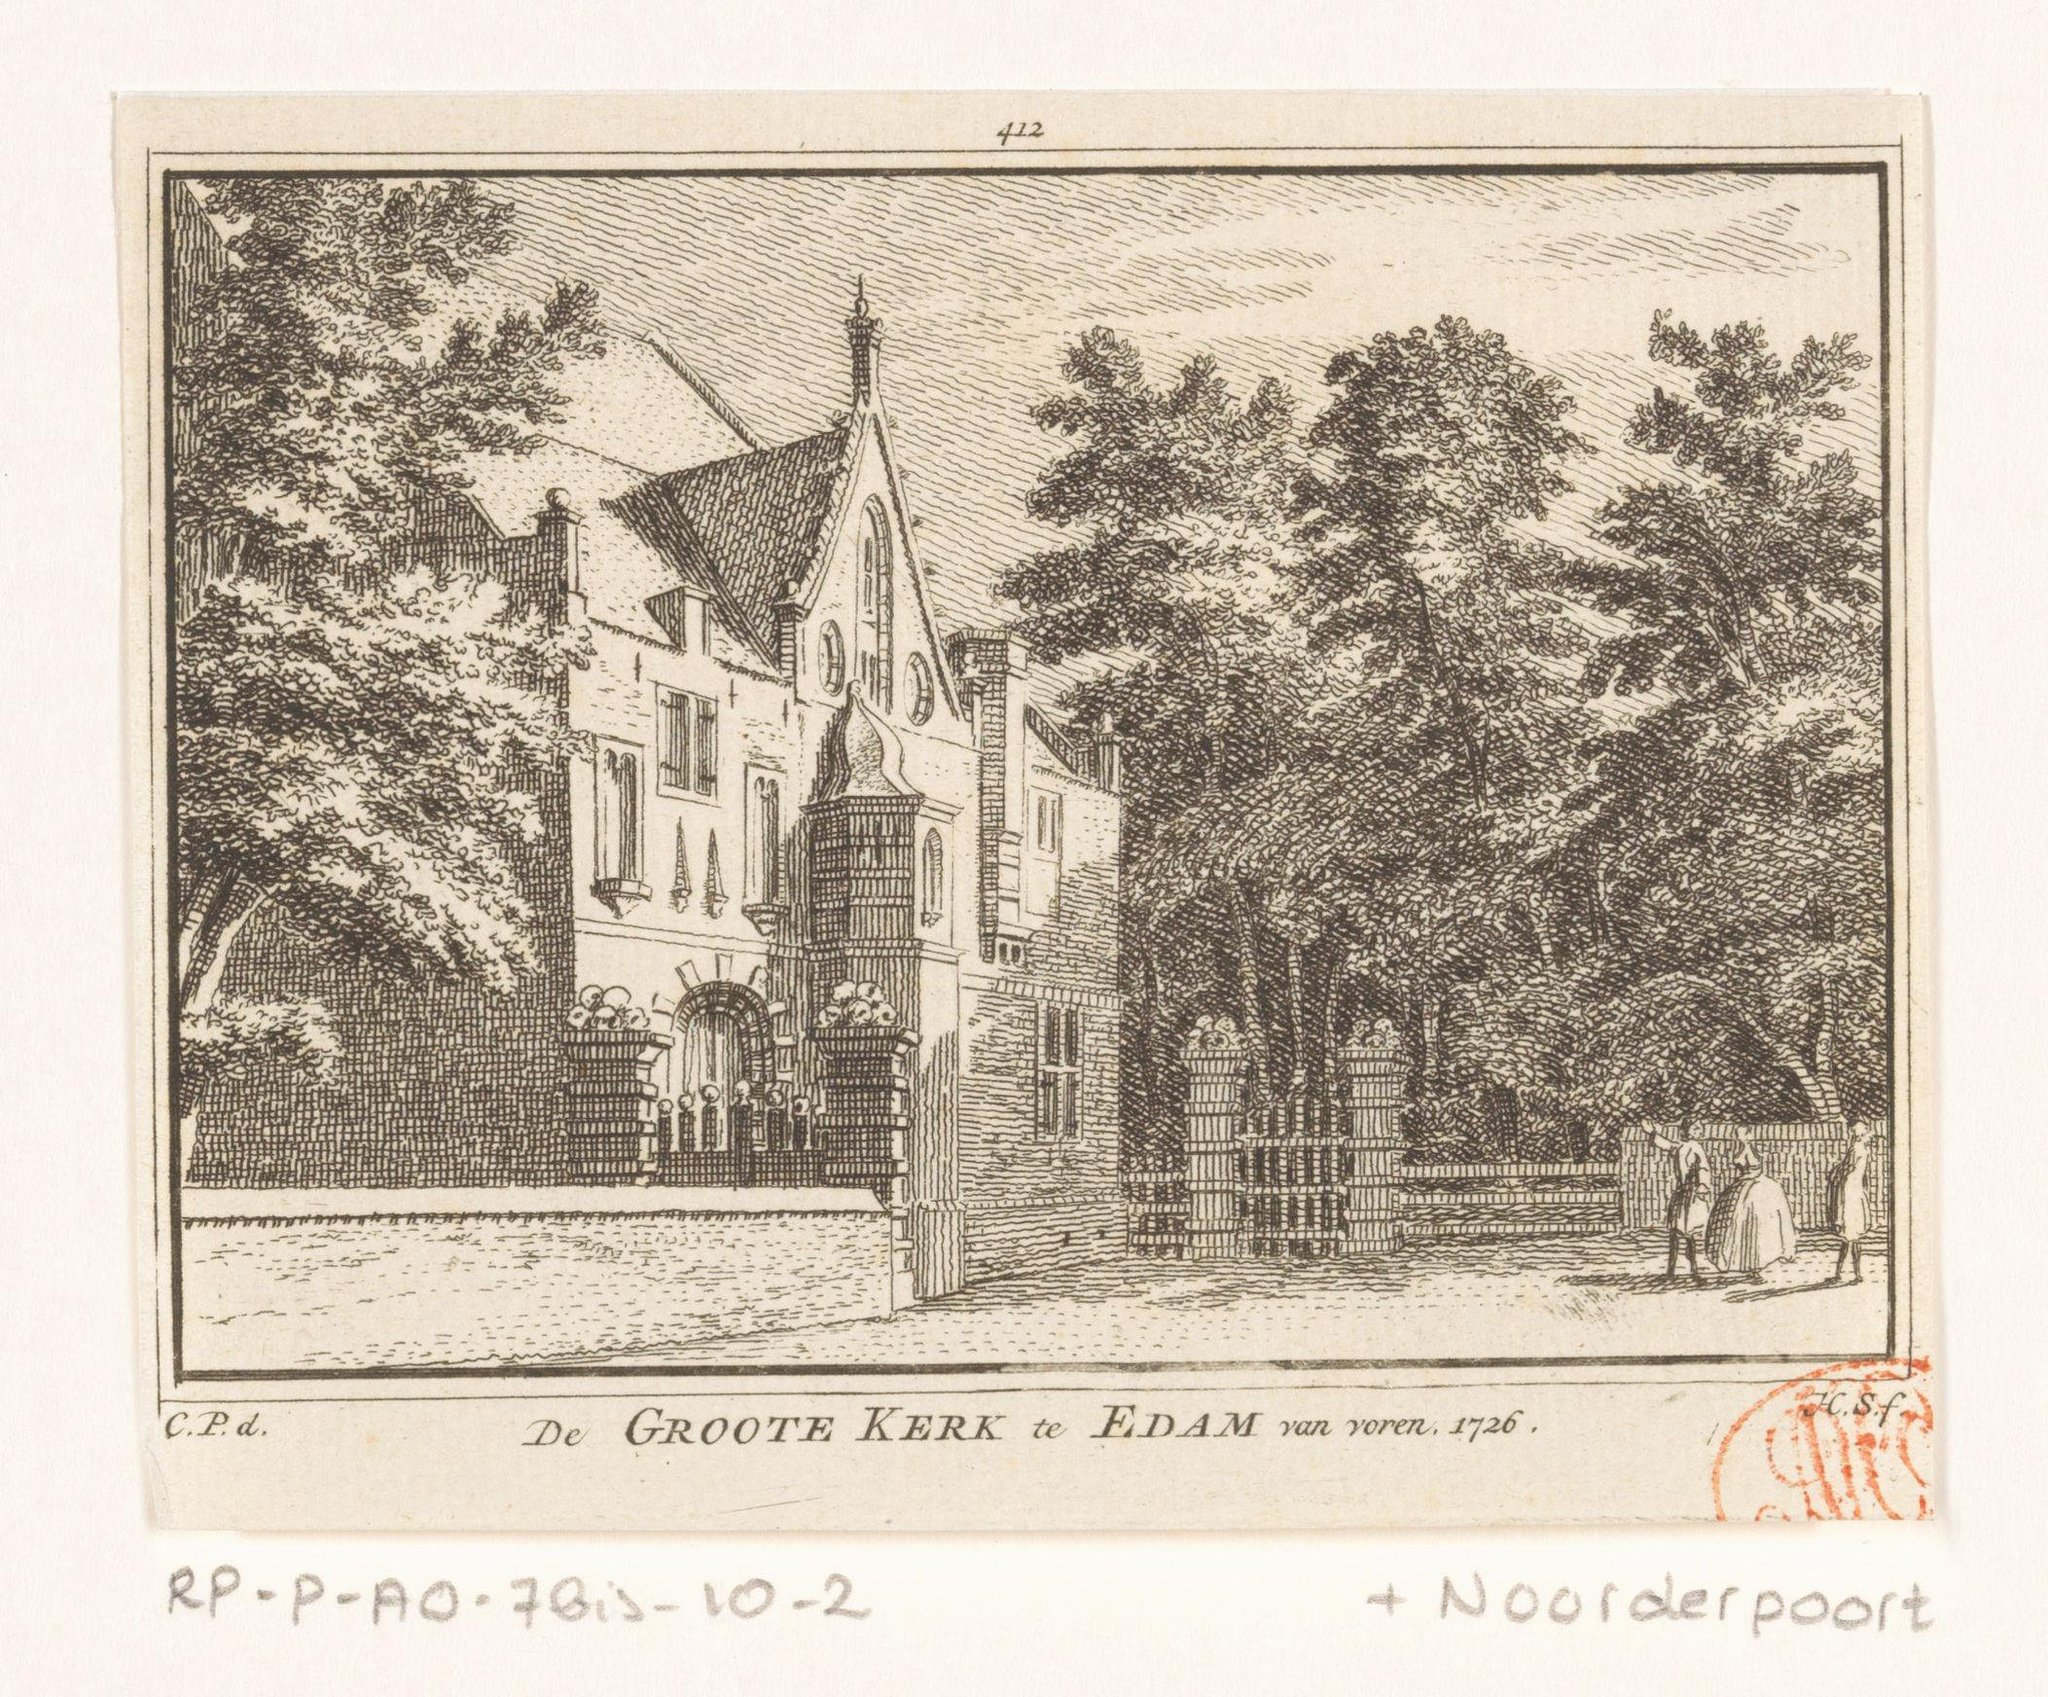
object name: print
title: Gezicht op de Grote Kerk te Edam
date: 1757-1792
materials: paper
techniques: engraving, etching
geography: haarlem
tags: church (exterior)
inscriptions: collector's mark: Lugt 195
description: Prent ook gebruikt in: Het verheerlykt Nederland of kabinet van hedendaagsche gezigten van steden, dorpen (…). 9 delen. Amsterdam: Isaak Tirion en weduwe Isaak Tirion, 1745-1774, dl. 6 (1757), ill. 412. Of in: Nederlandsche tafereelen; of eene keurige verzameling van negen honderd fraaije gezigten van steden, dorpen, sloten, oudheden (….). 9 delen. Amsterdam: Jan de Groot, 1792, dl. 6, ill. 412. Uit welke druk het huidige exemplaar precies komt is niet na te gaan.